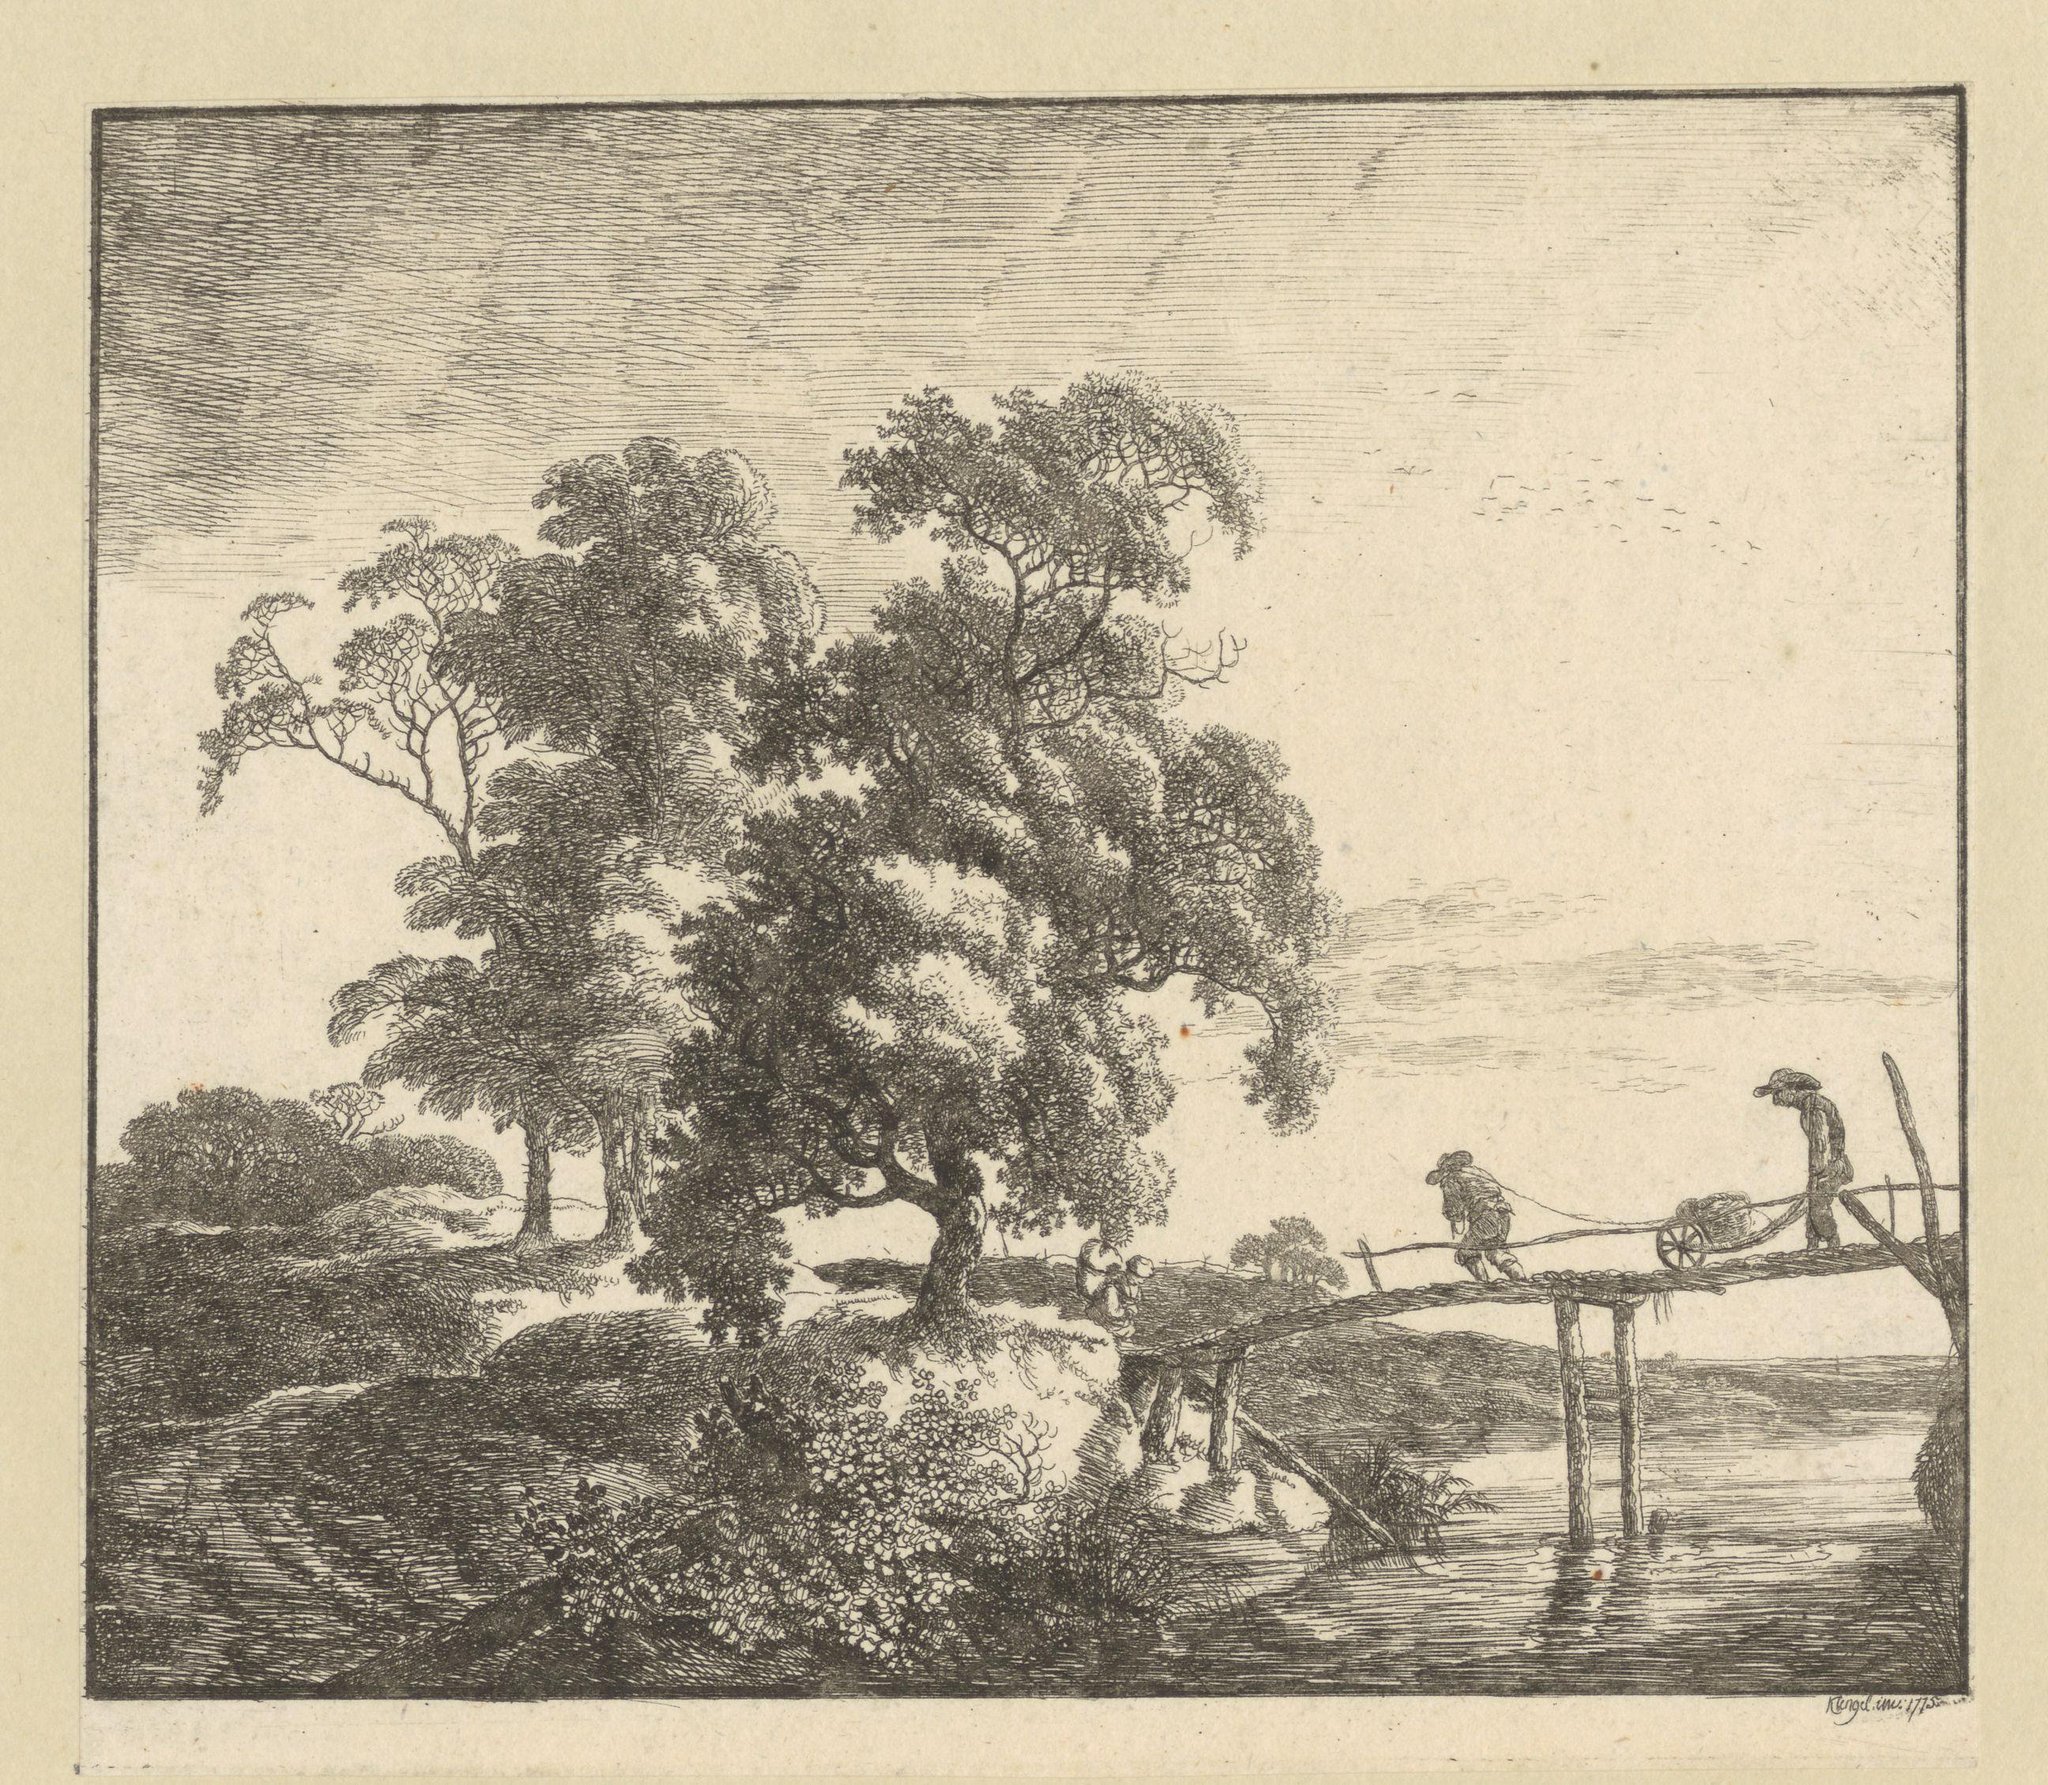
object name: print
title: Landschap met twee mannen met kruiwagen op houten brug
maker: johann christian klengel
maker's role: print maker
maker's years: 1751-1824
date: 1775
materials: paper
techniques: etching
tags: landscape with bridge, viaduct or aqueduct, wheelbarrow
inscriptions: collector's mark: Lugt 240